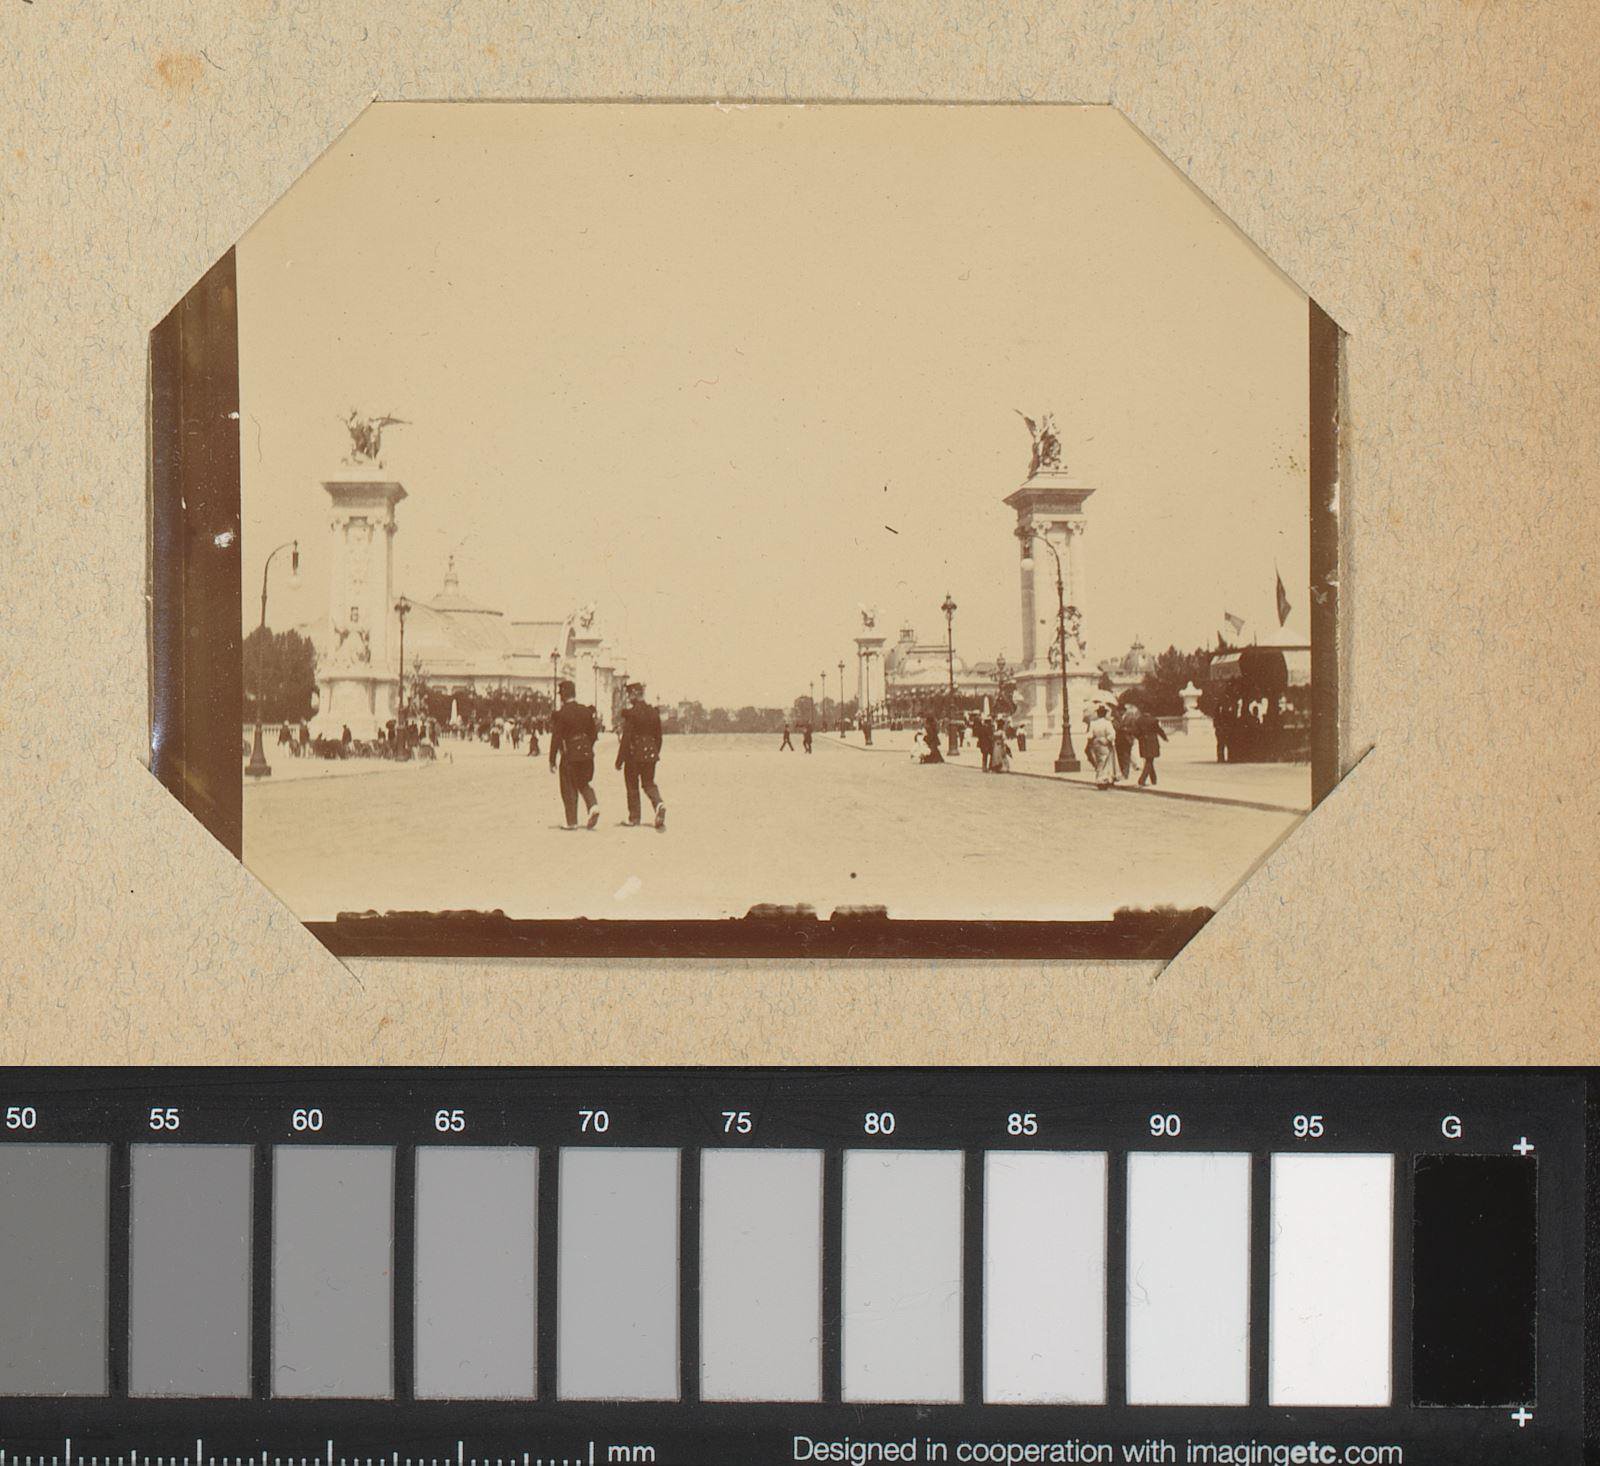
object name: photograph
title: Gezicht op de Pont Alexandre III richting Grand Palais, tijdens de Wereldtentoonstelling van 1900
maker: Anonymous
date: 1900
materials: paper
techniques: gelatin silver print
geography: paris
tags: world fair, world exhibition, avenue, boulevard, promenade, esplanade, paris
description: Over de foto is een ander negatief afgedrukt van een voorstelling van bomen.